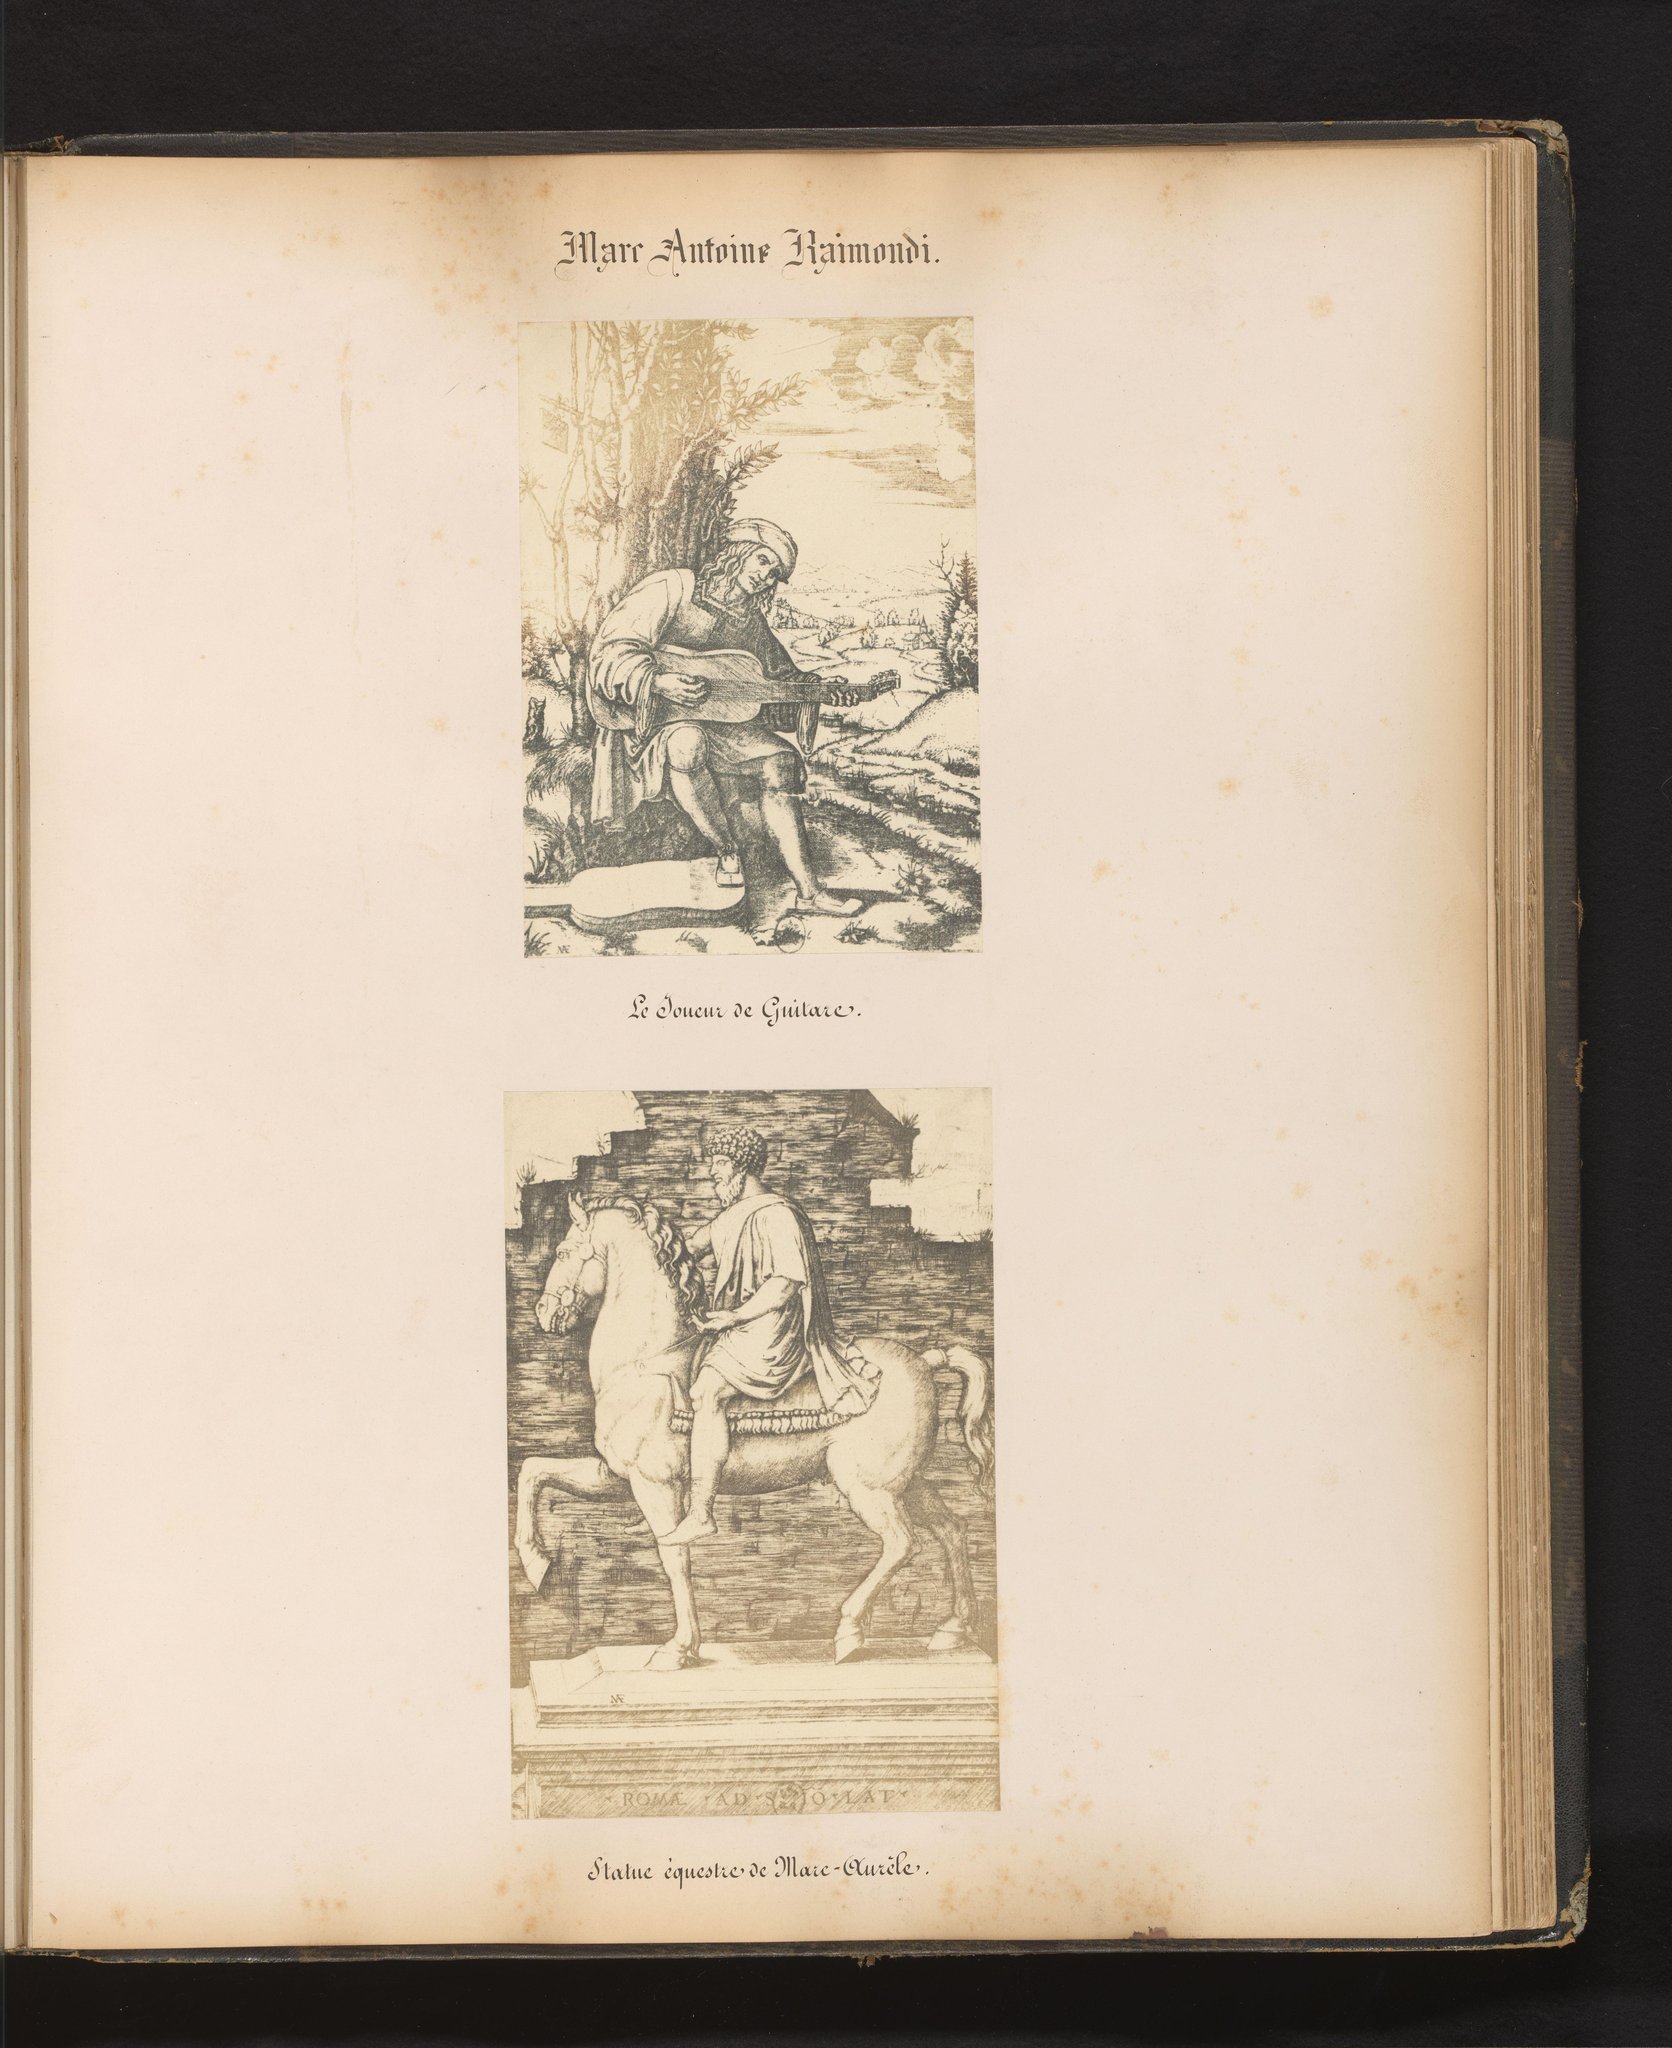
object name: reproduction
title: Fotoreproductie van een gravure van een man met een gitaar, mogelijk Jean-Philotée Achillini, door Marcantonio Raimondi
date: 1848-1853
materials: photographic support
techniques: salted paper print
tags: cithern, mandolin, guitar, balalaika (+ artist at work)